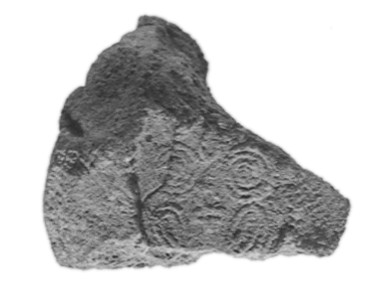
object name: sealing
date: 2030-1640 BCE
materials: clay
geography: egypt